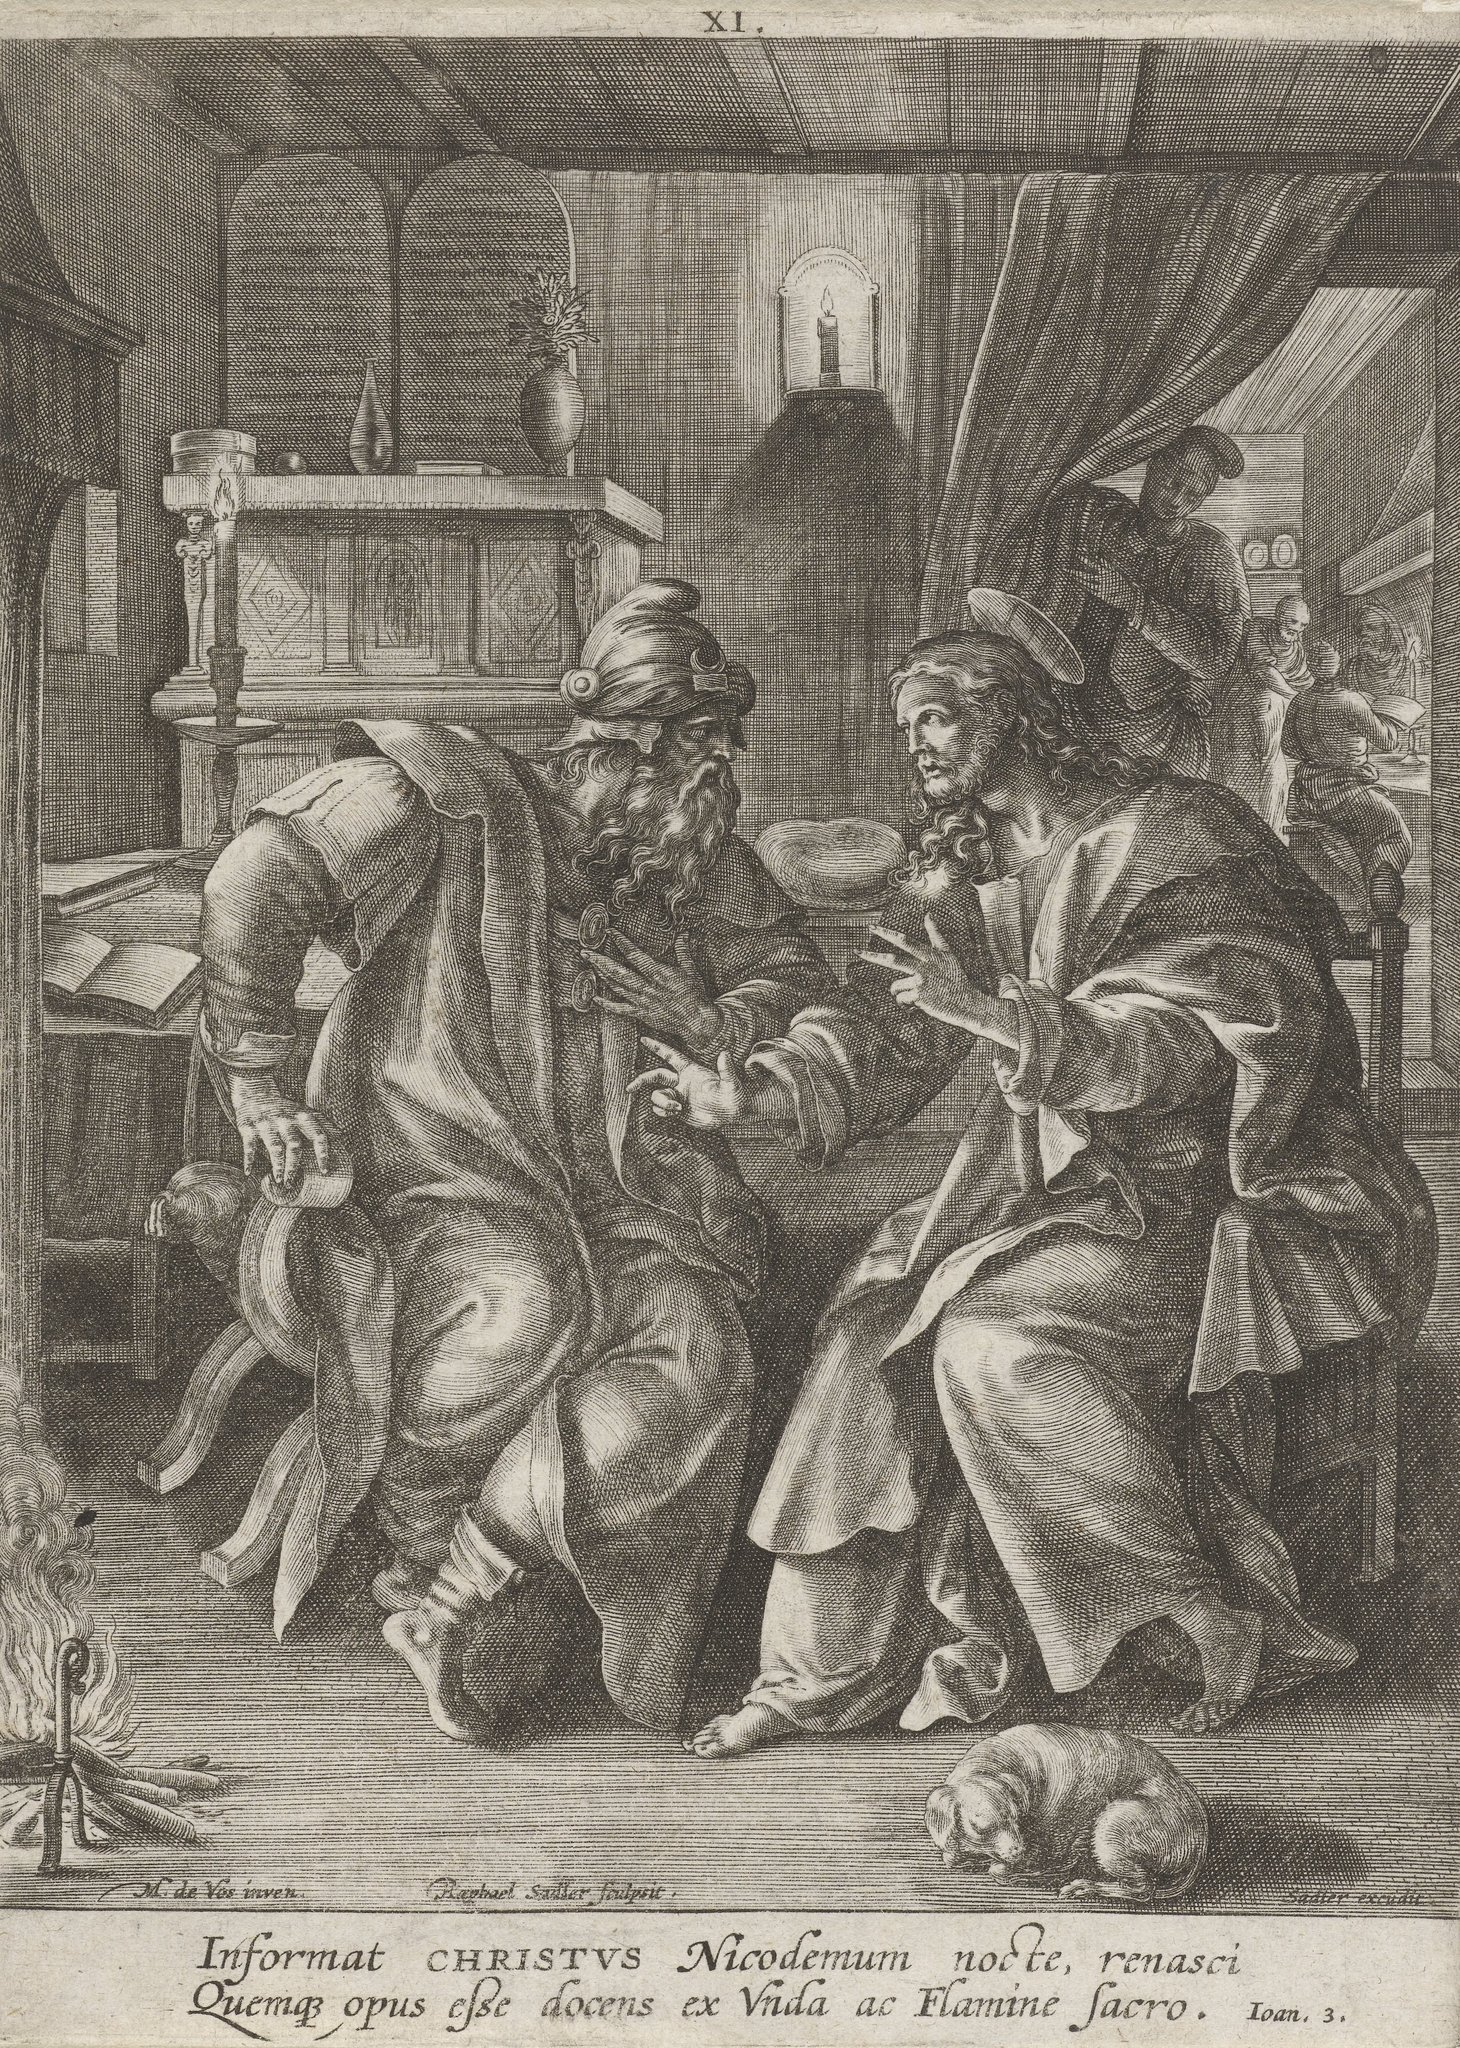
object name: print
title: Leven van Christus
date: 1583-1588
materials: paper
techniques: engraving, etching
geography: antwerp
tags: christ talking with nicodemus at night (john 3:1-21)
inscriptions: collector's mark: Lugt 2228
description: Het interieur van een huis. De farizeeër Nikodemus is in gesprek met Christus in het midden van de nacht (Joh. 3:1-21). De prent heeft een Latijns onderschrift en maakt deel uit van een serie over het leven van Christus.